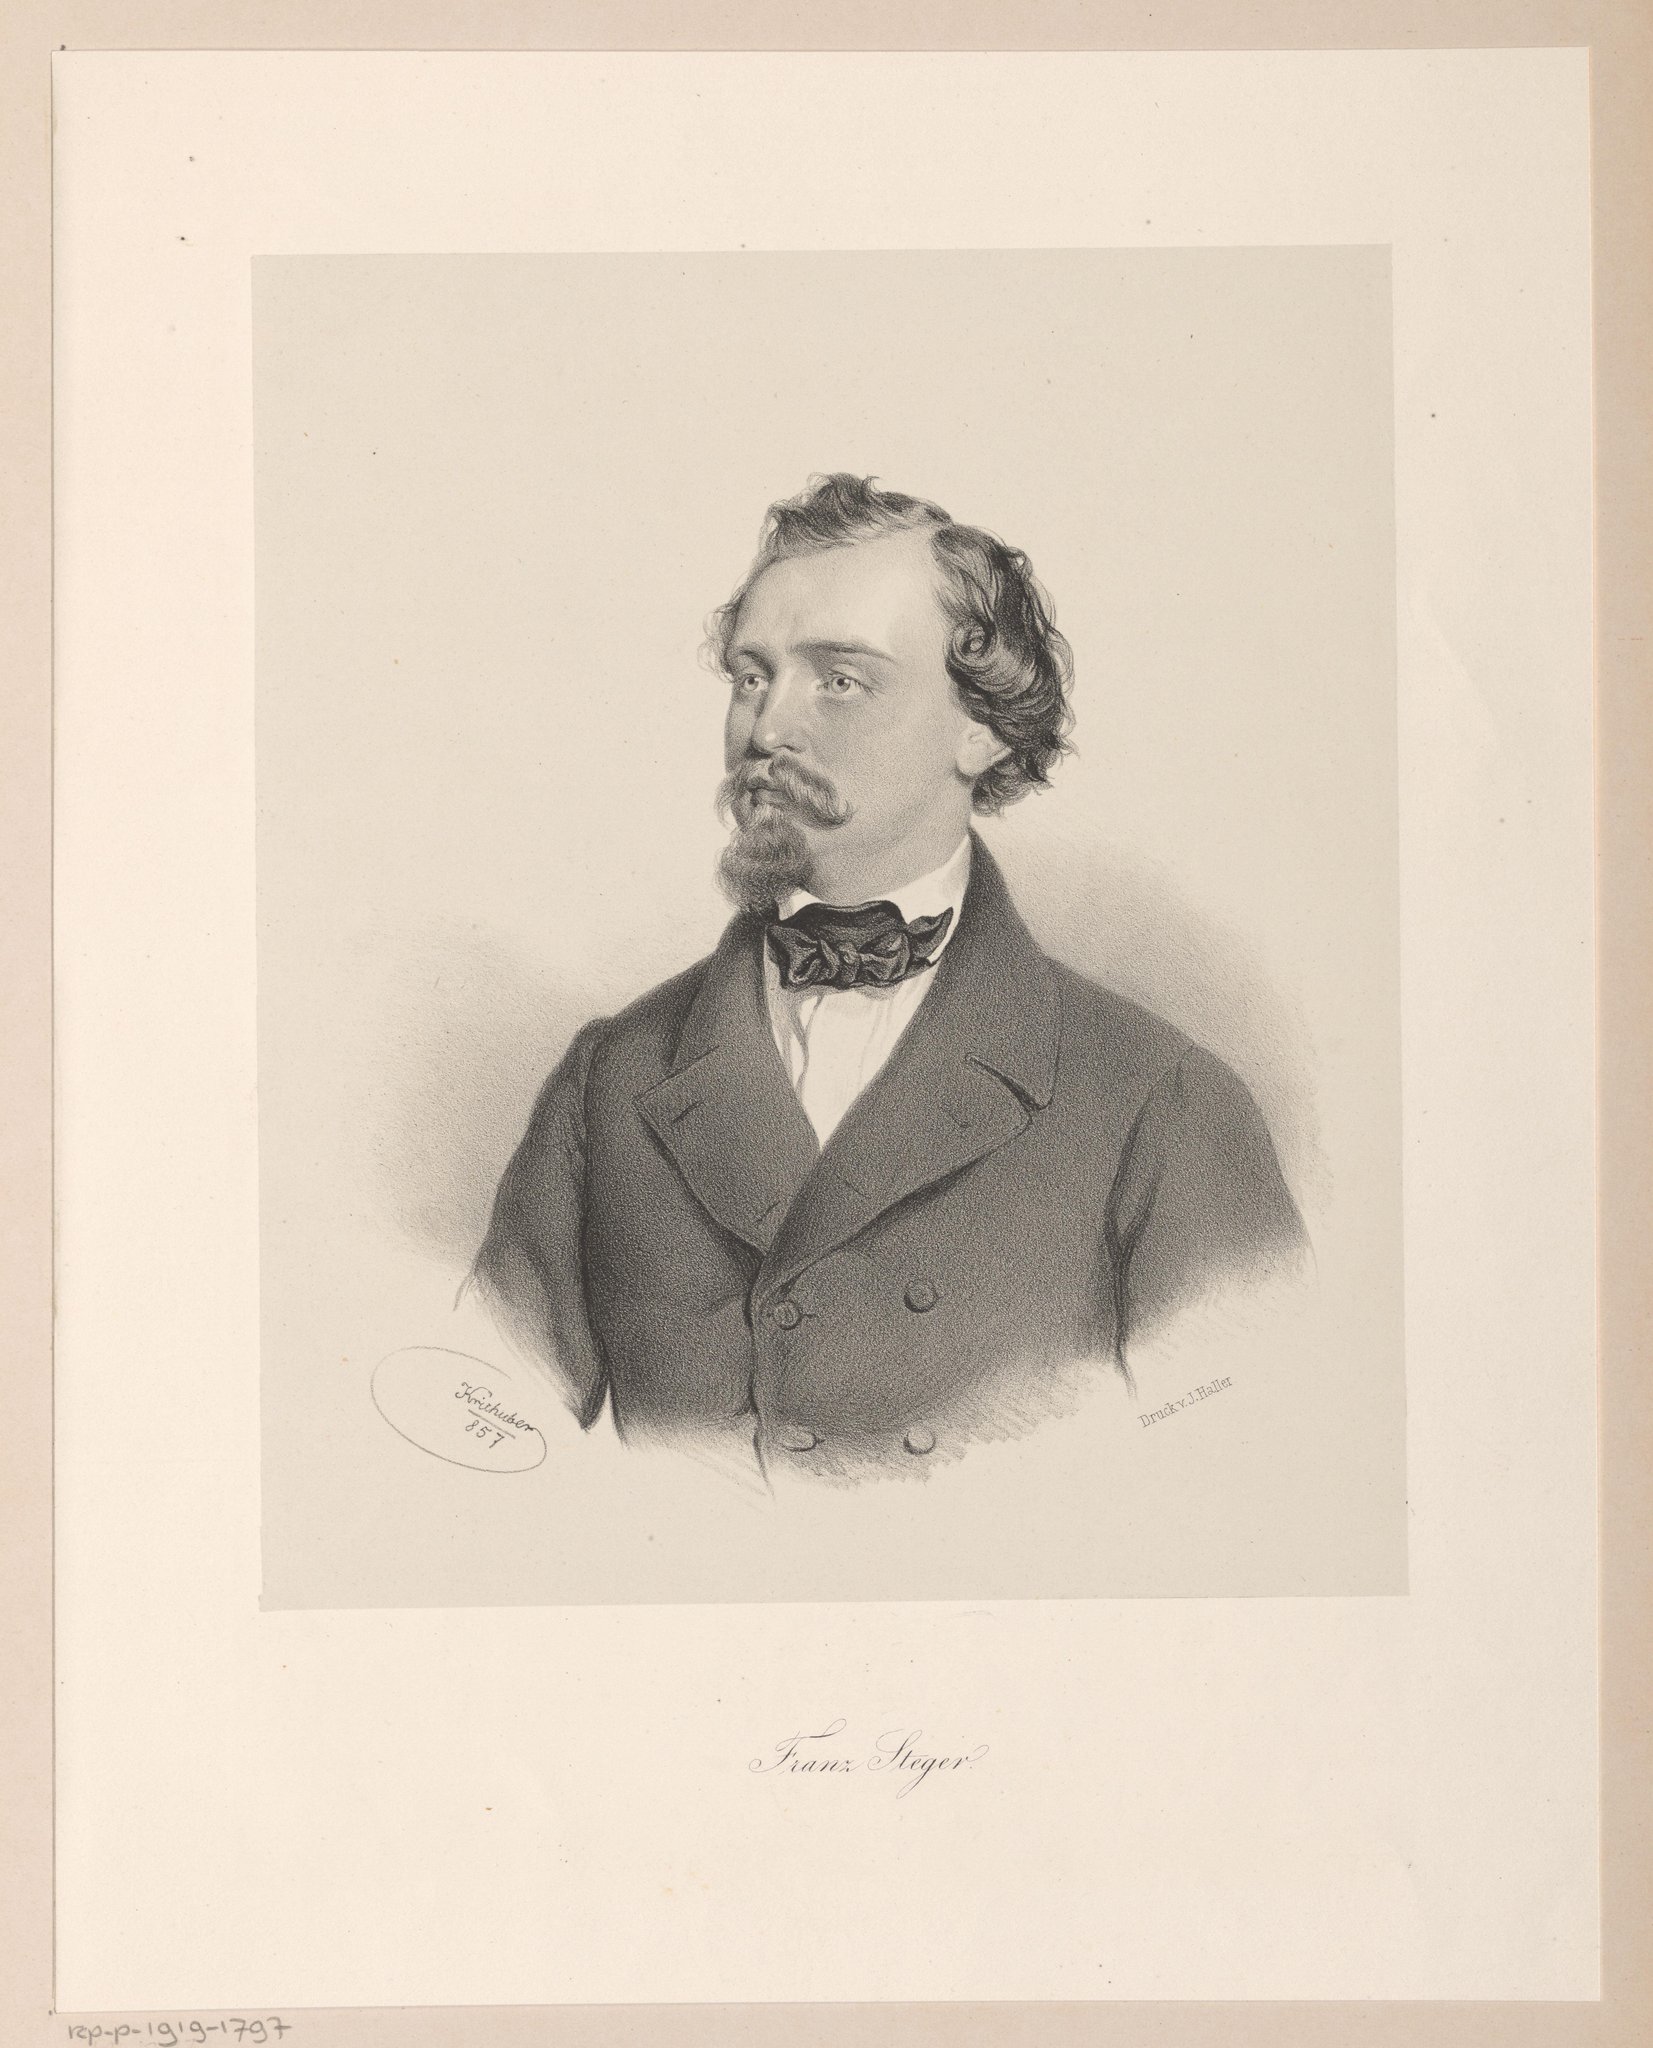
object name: print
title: Portret van Franz Steger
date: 1857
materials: paper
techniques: lithograph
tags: historical persons, opera-singer (male)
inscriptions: collector's mark: Lugt 2228